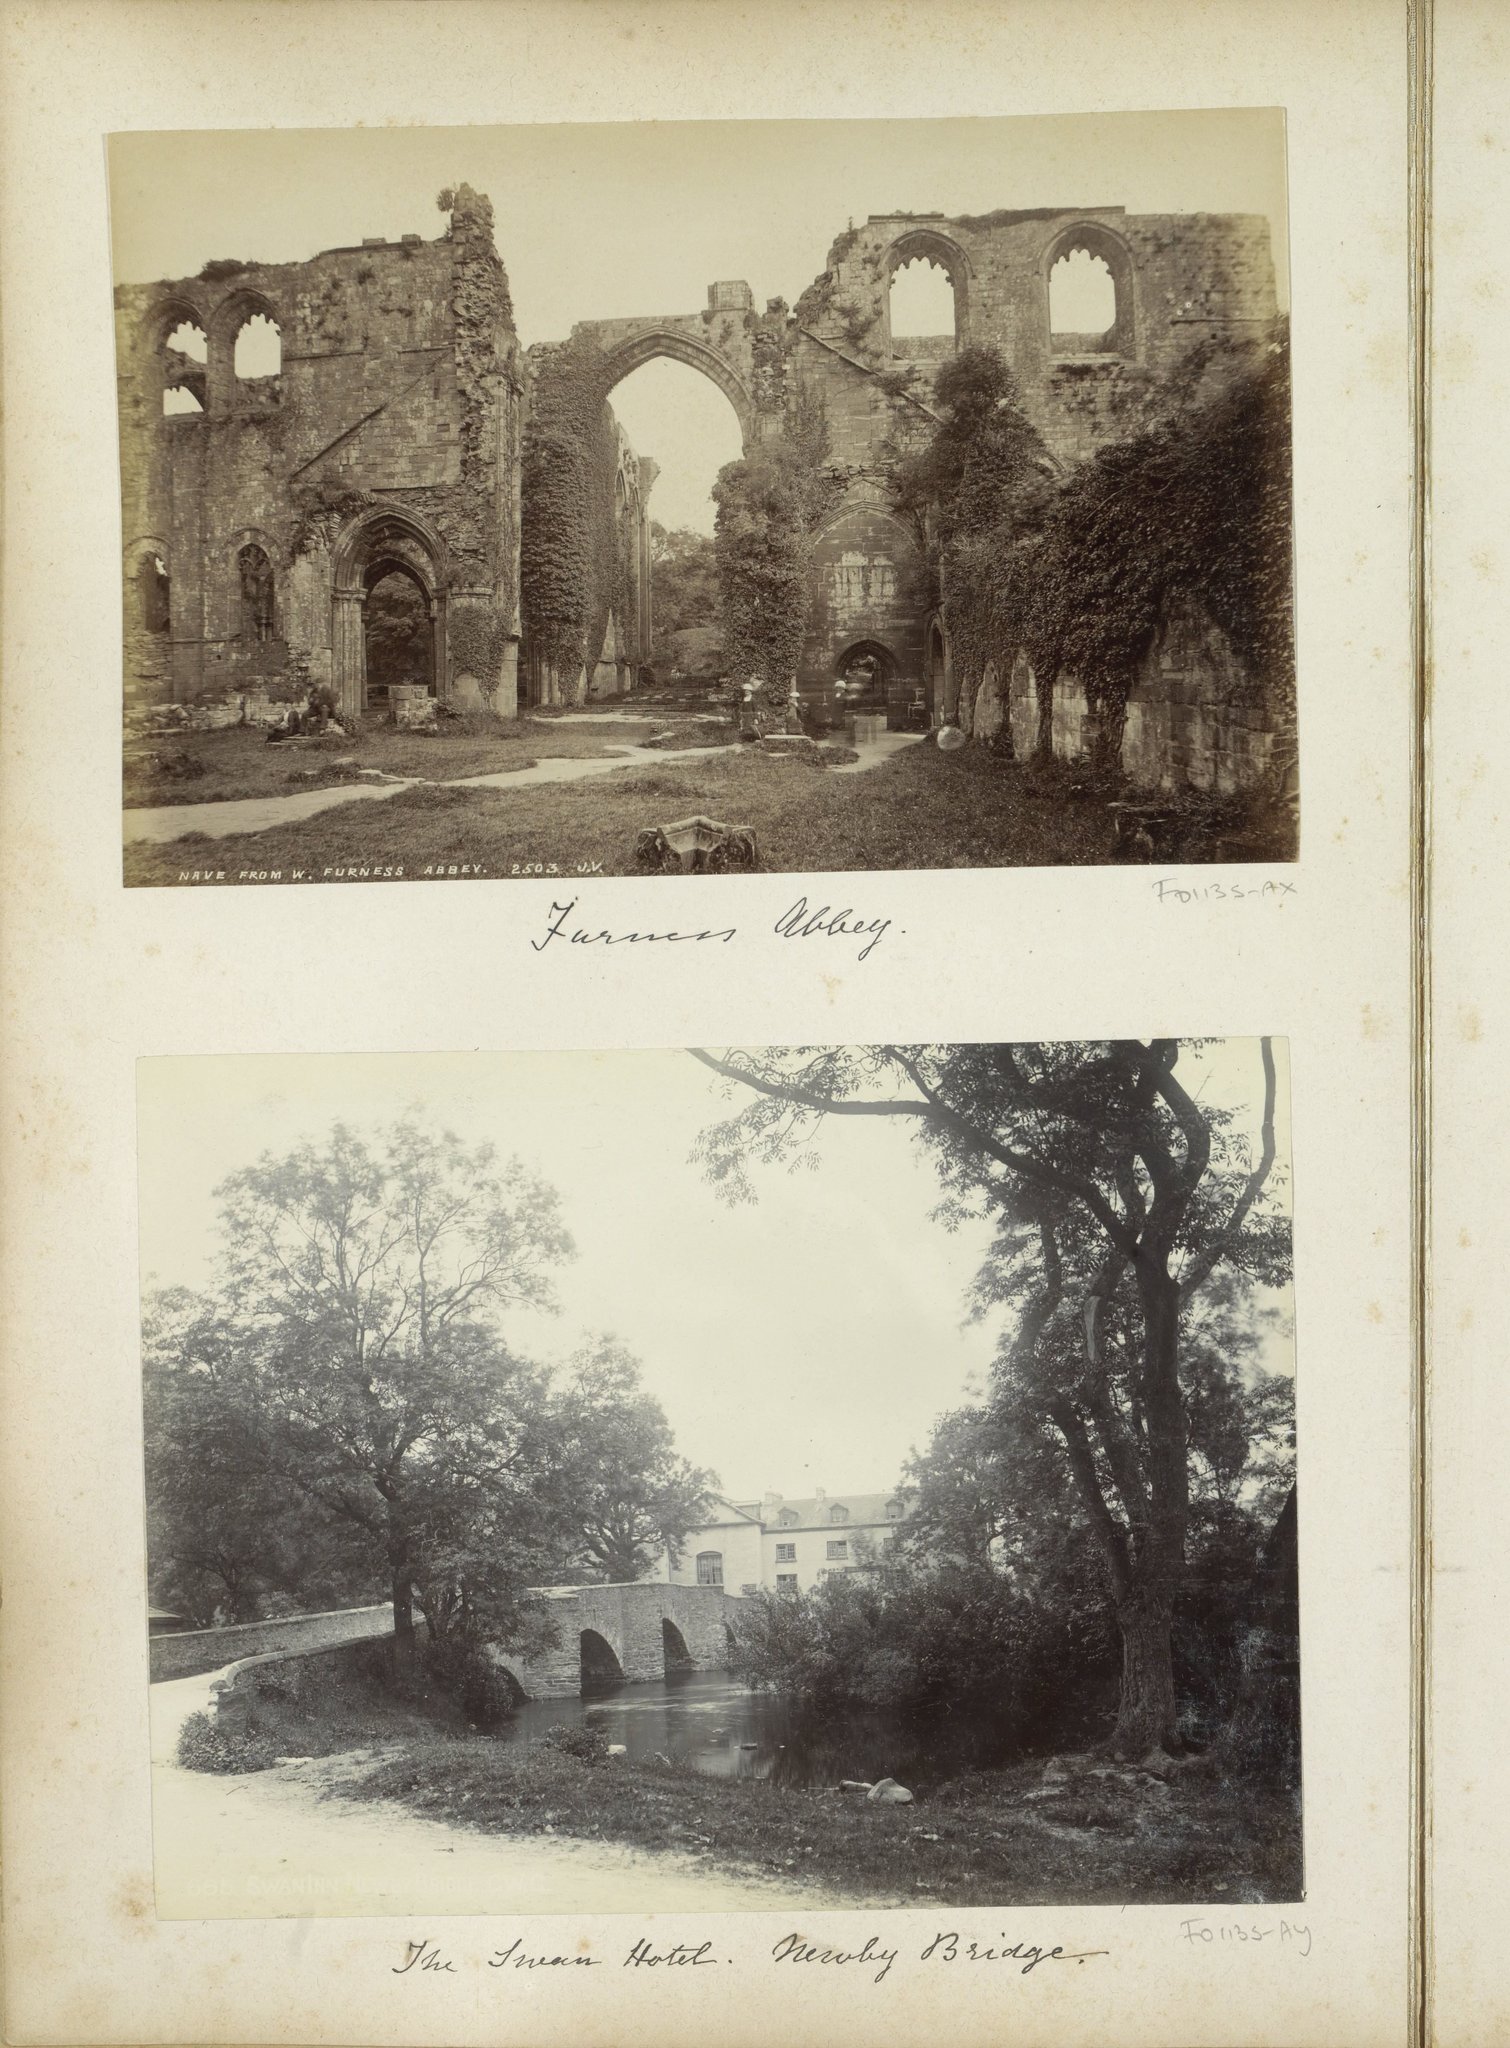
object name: album leaf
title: Gezicht op The Swan Hotel in Newby Bridge met op de voorgrond een stenen brug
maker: Anonymous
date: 1899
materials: paper, photographic support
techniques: daylight paper print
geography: newby bridge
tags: bridge, hotel, hostelry, inn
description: Onderdeel van Reisalbum met foto's van bezienswaardigheden in Engeland en Frankrijk.